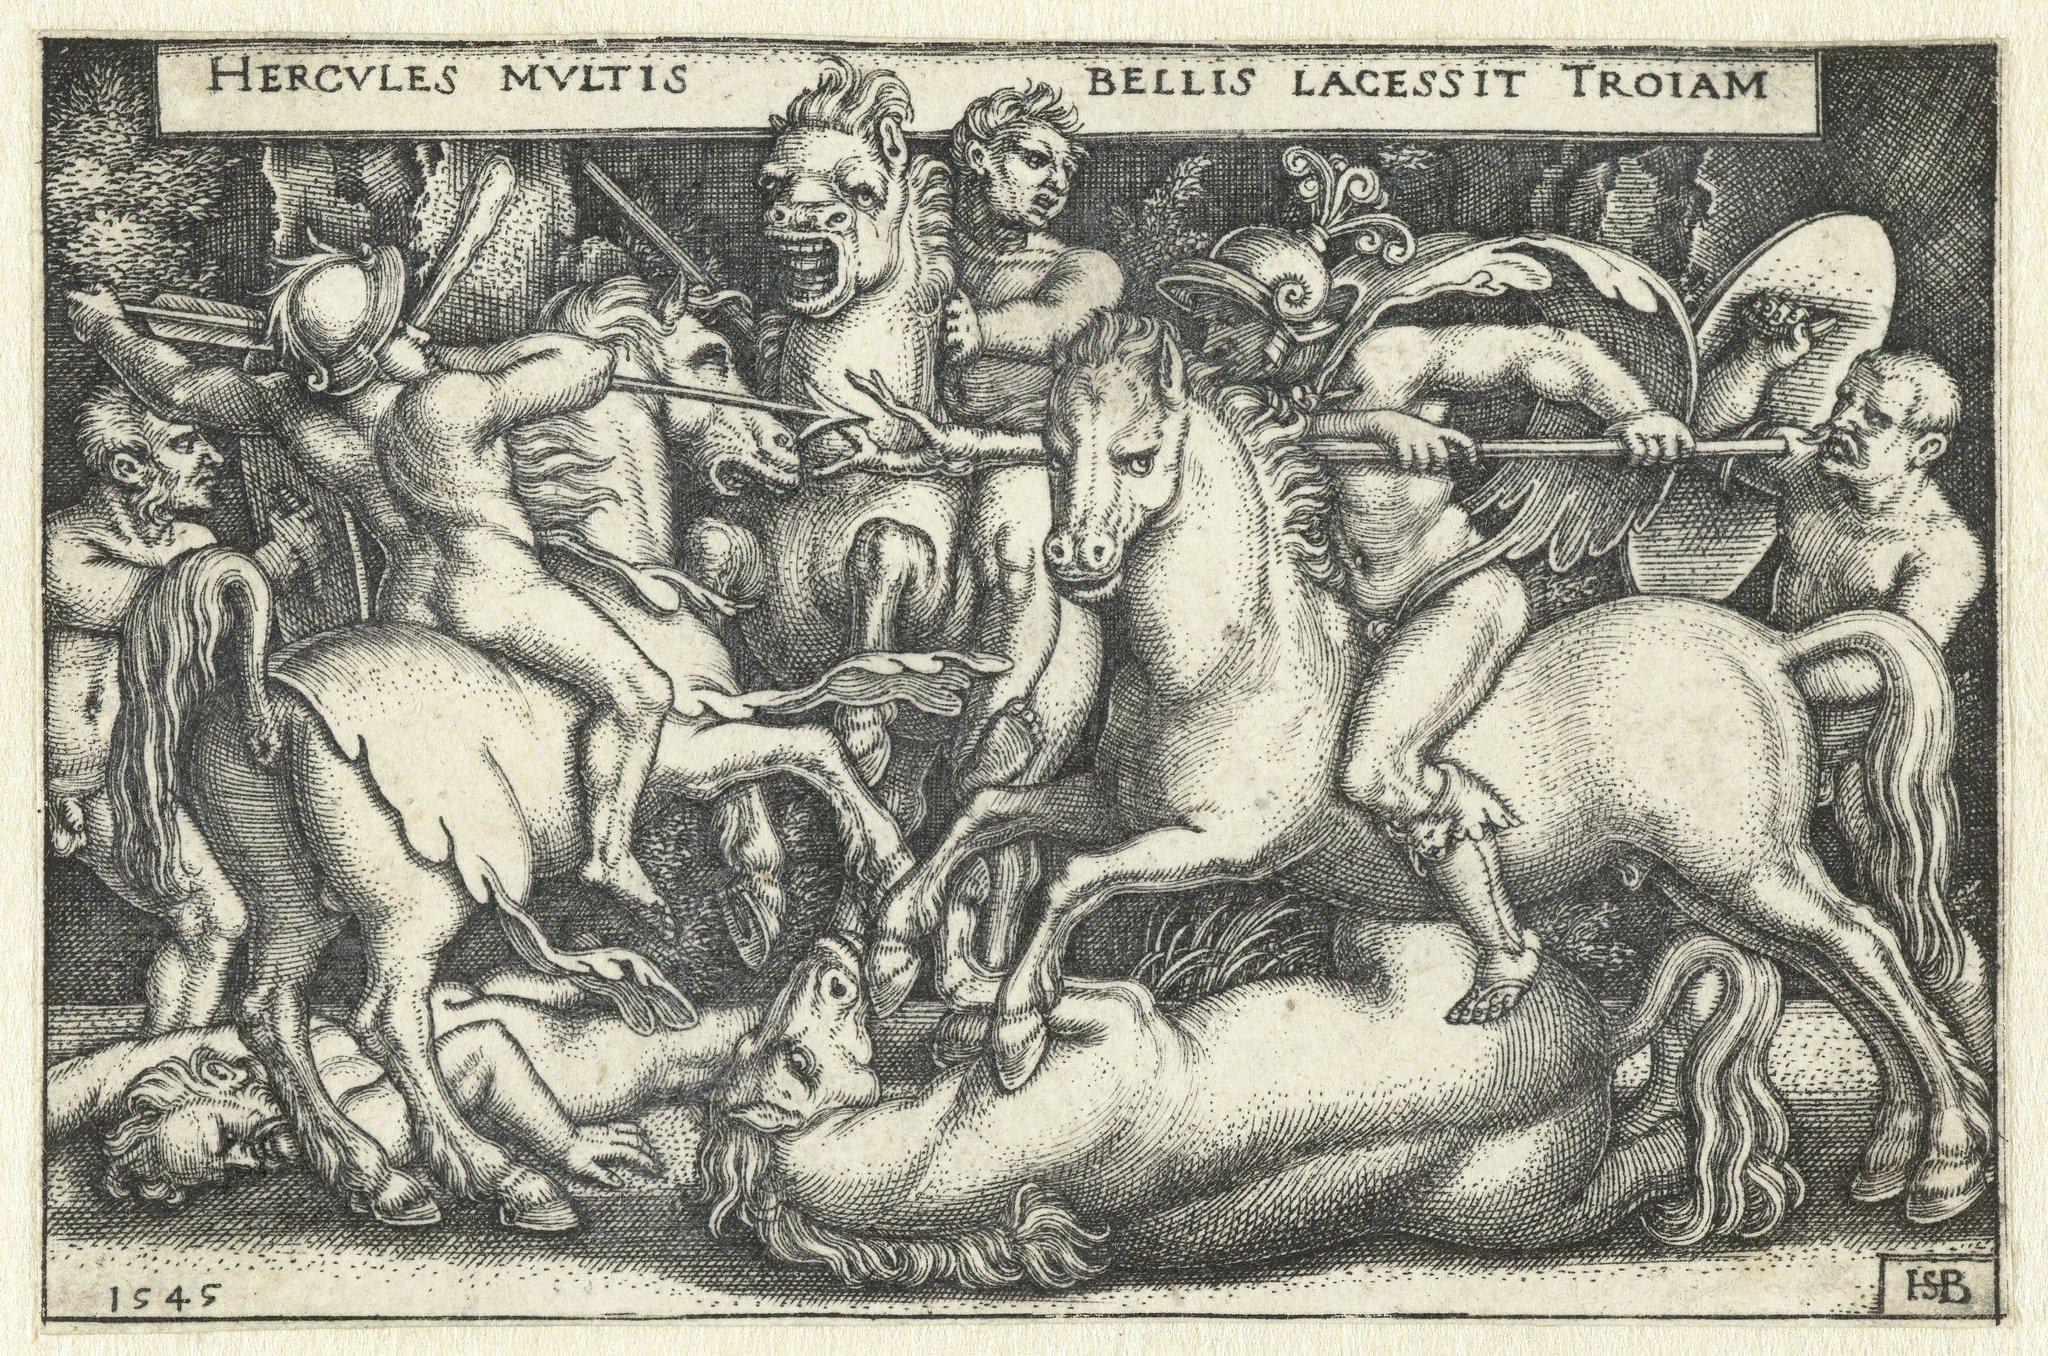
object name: print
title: Hercvles mvltis bellis lacessit Troiam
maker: hans sebald beham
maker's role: designer, draughtsman, print maker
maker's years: 1500-1550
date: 1545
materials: paper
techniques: engraving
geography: frankfurt am main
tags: (story of) hercules (heracles), the trojan war (94c - 94h)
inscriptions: collector's mark: Lugt 2228a